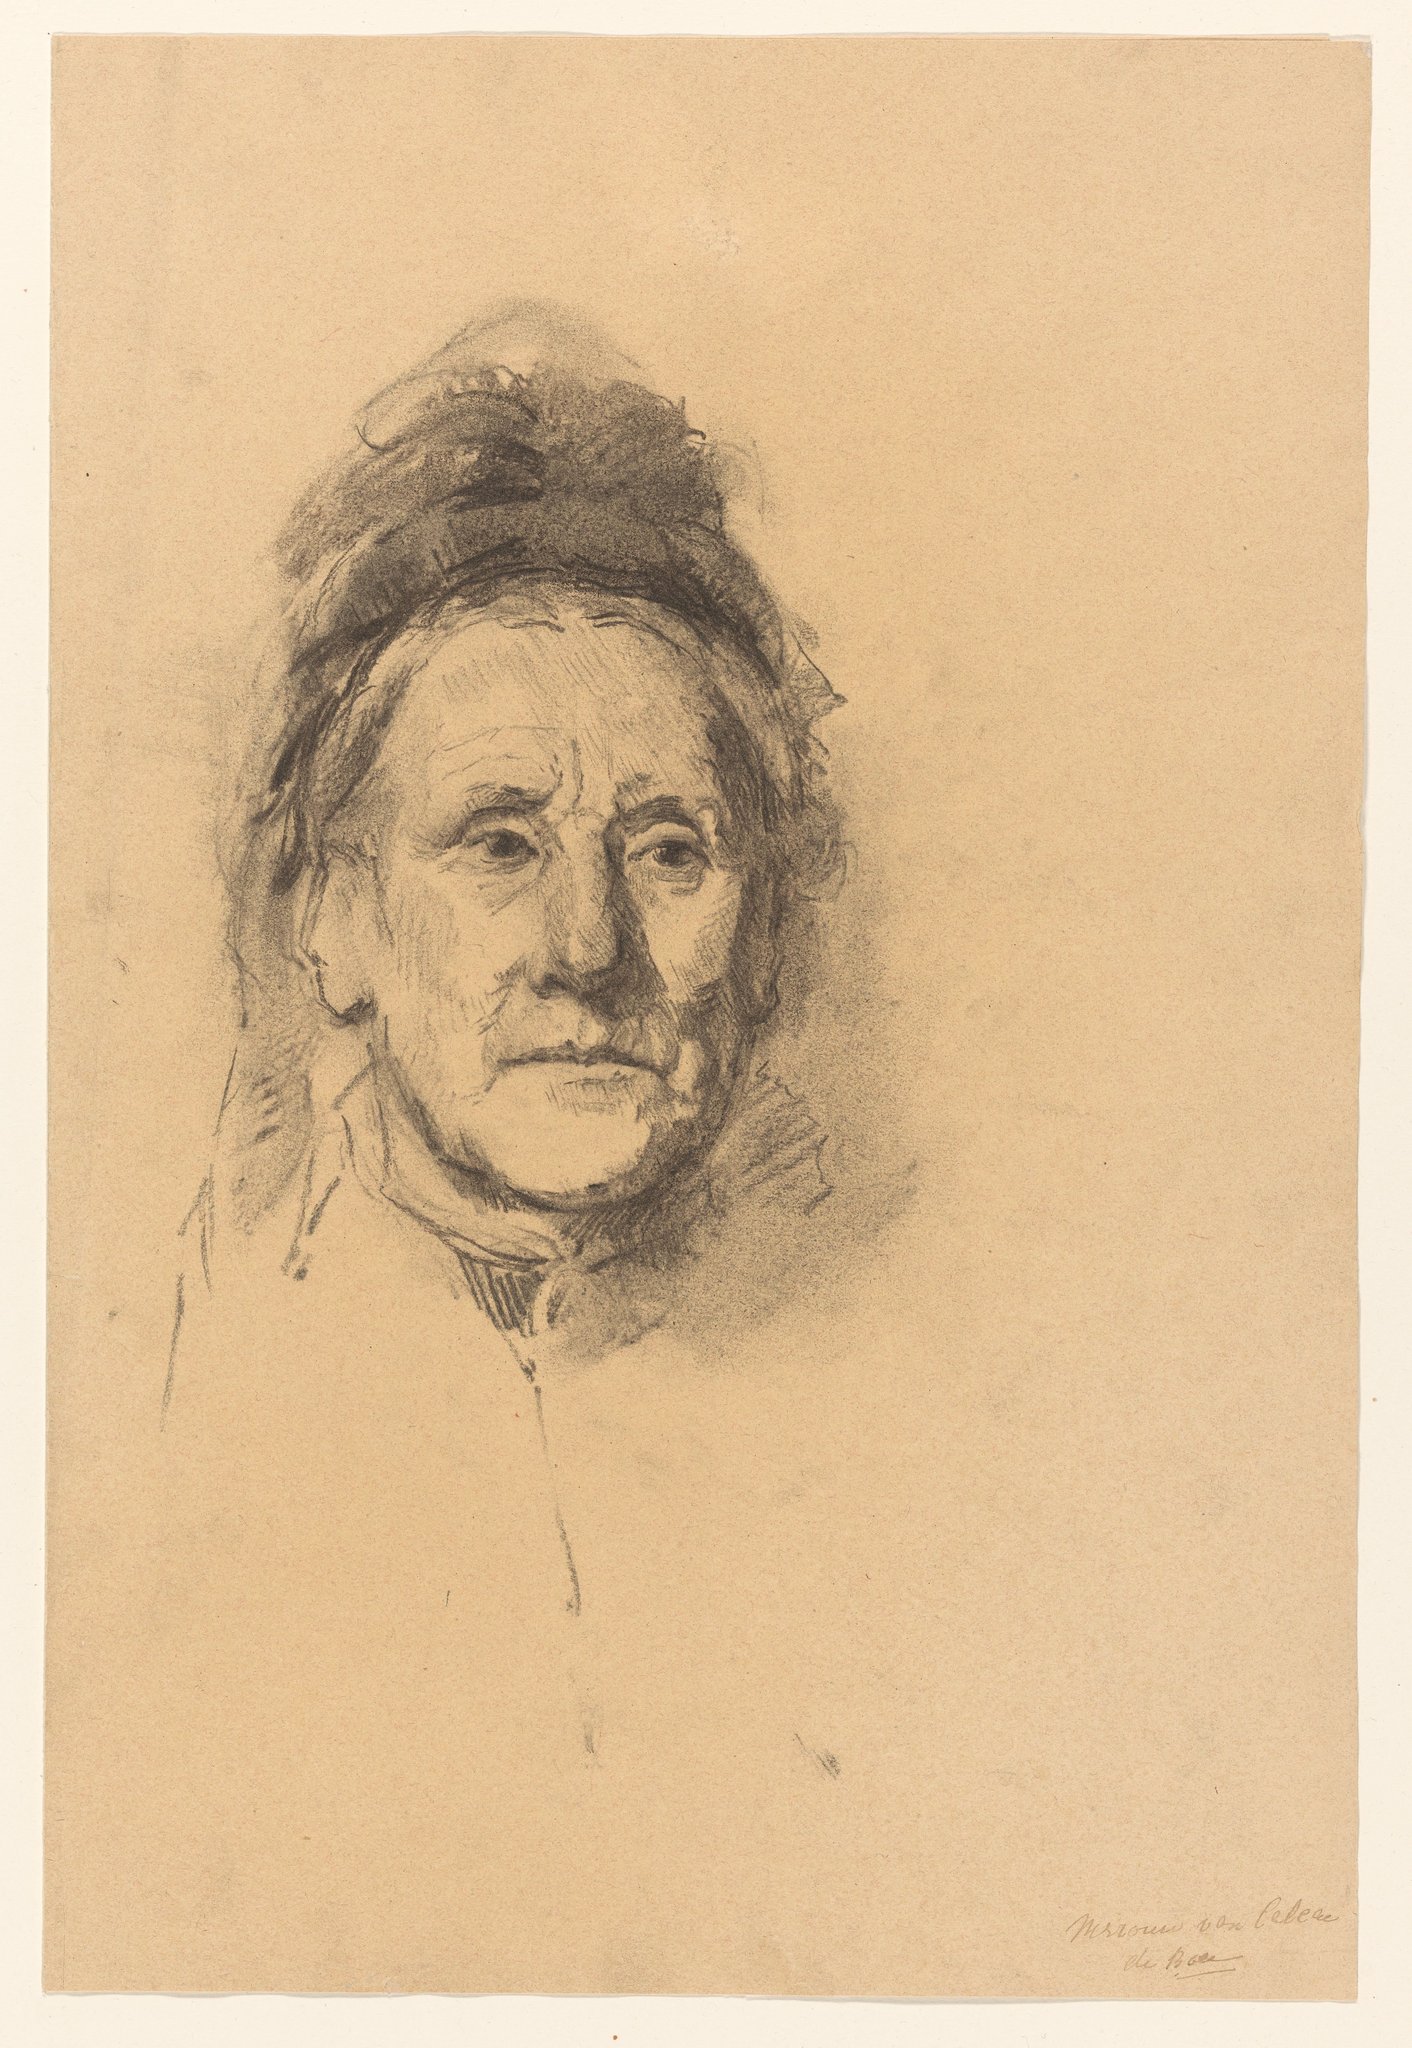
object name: drawing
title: Portret van mevrouw Van Calcar-de Boer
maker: barbara elisabeth van houten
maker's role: draughtsman, print maker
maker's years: 1862-1950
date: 1872-1950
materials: charcoal, paper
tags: historical persons